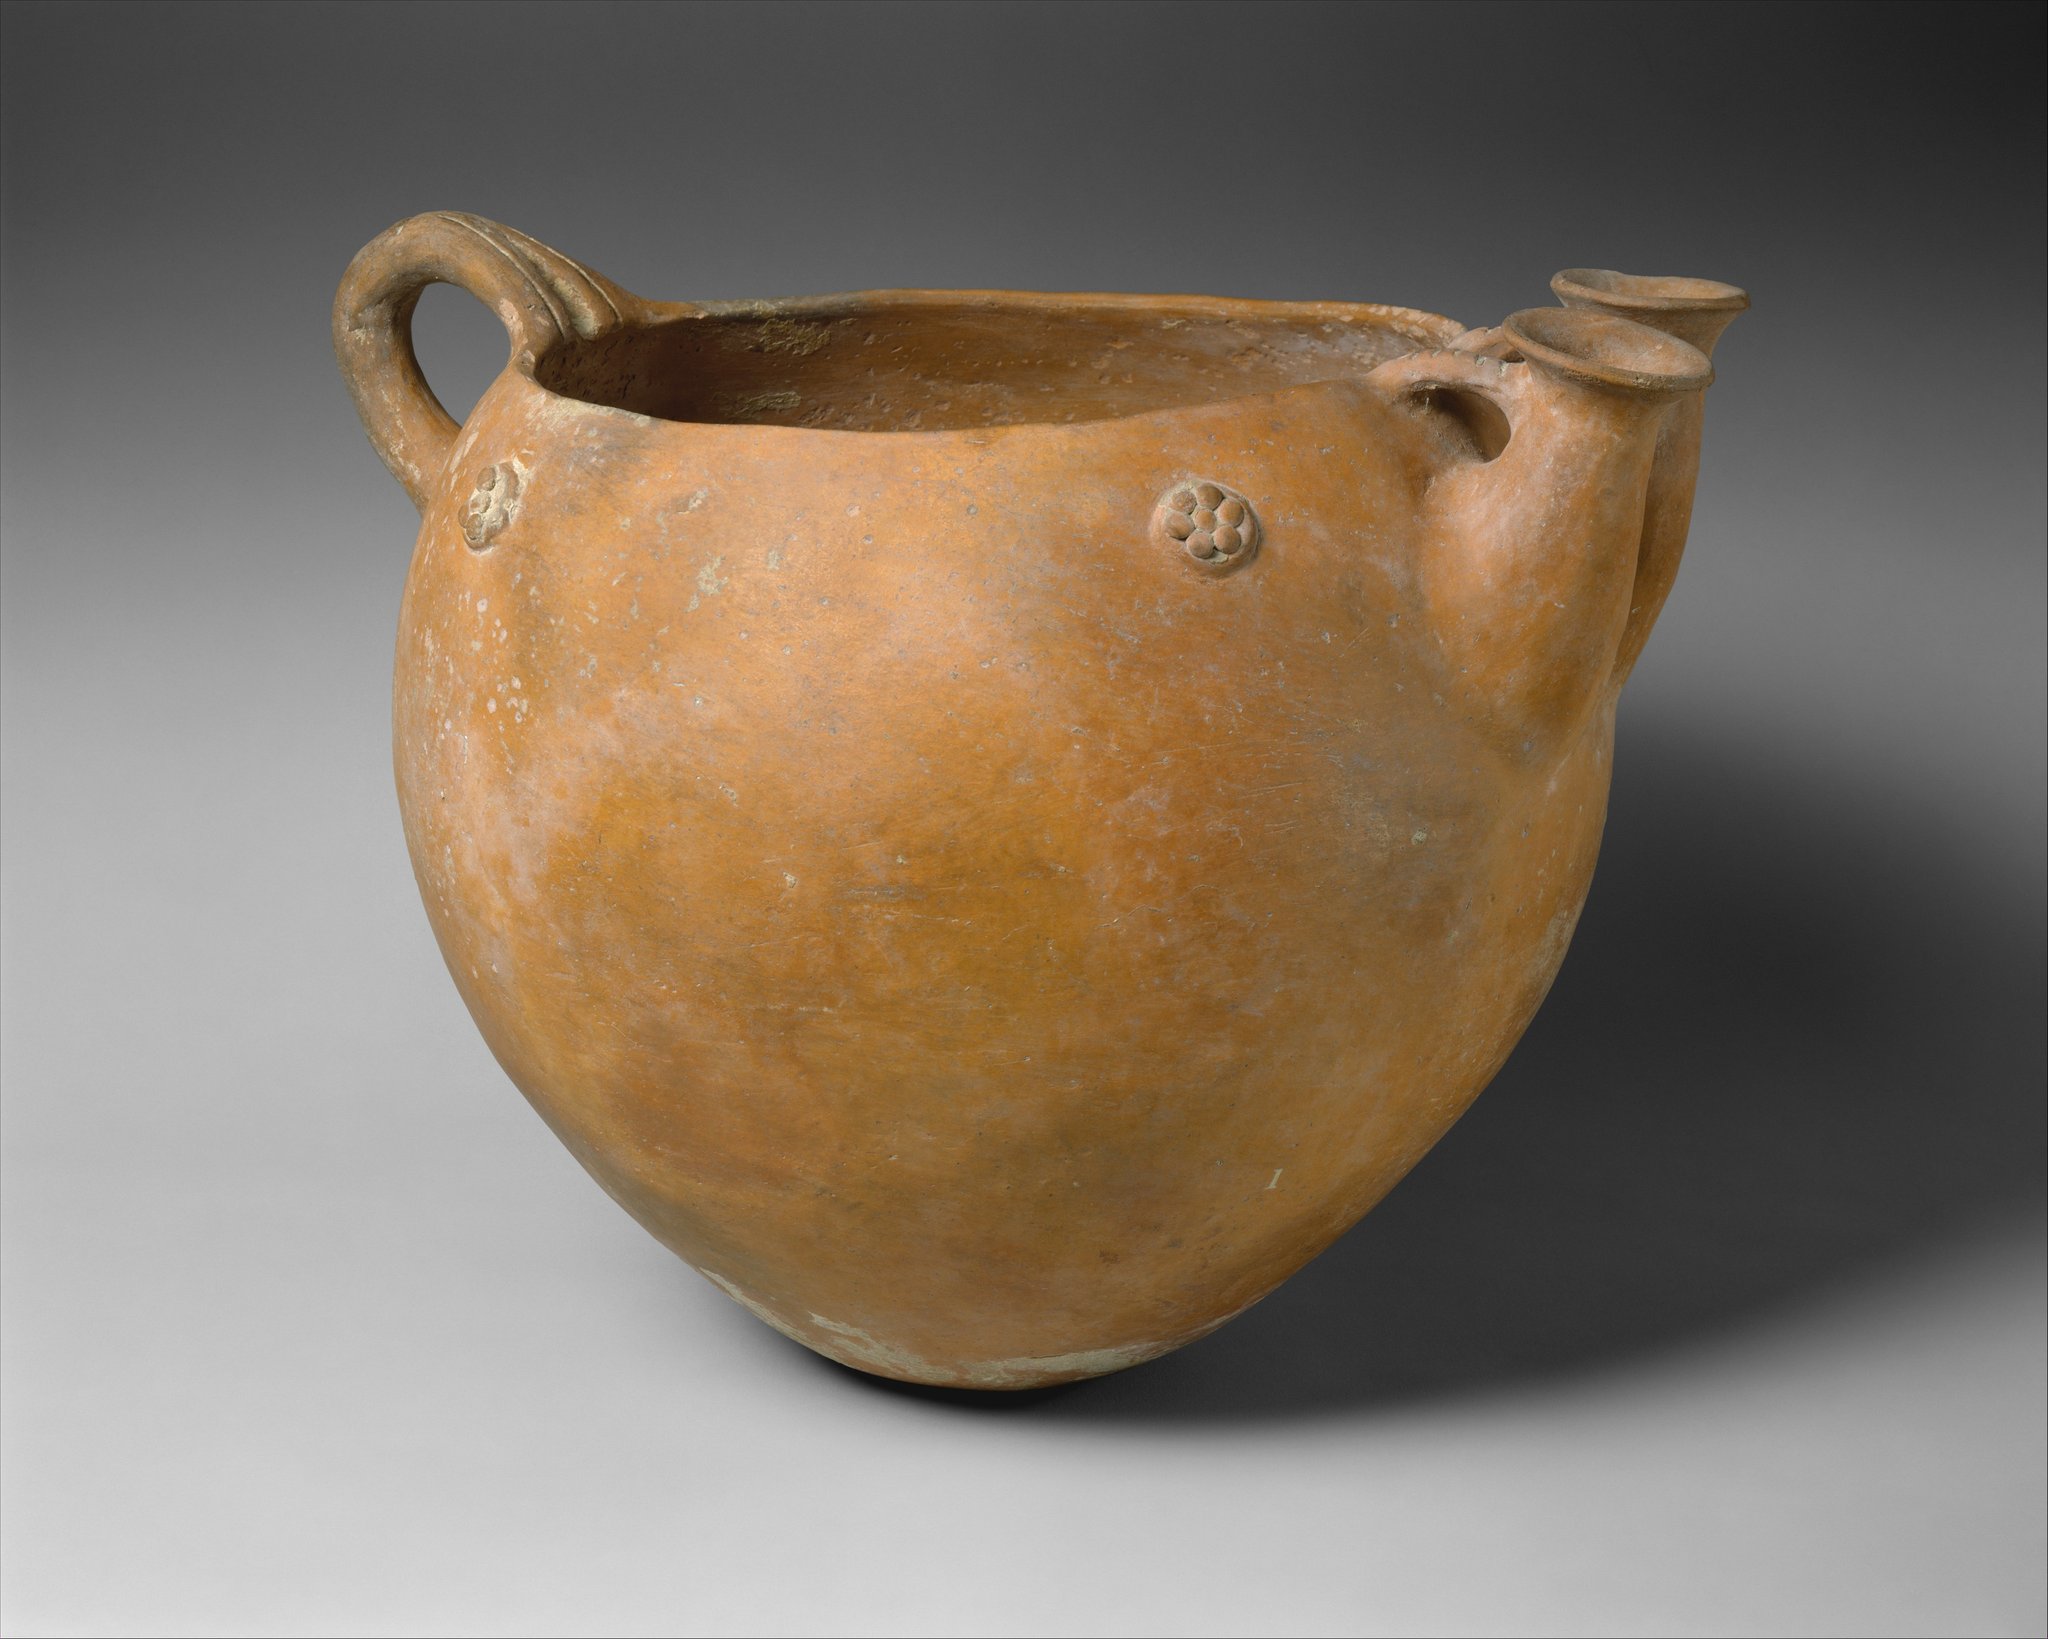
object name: bowl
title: Terracotta bowl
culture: cypriot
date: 2500-1600 BCE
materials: terracotta